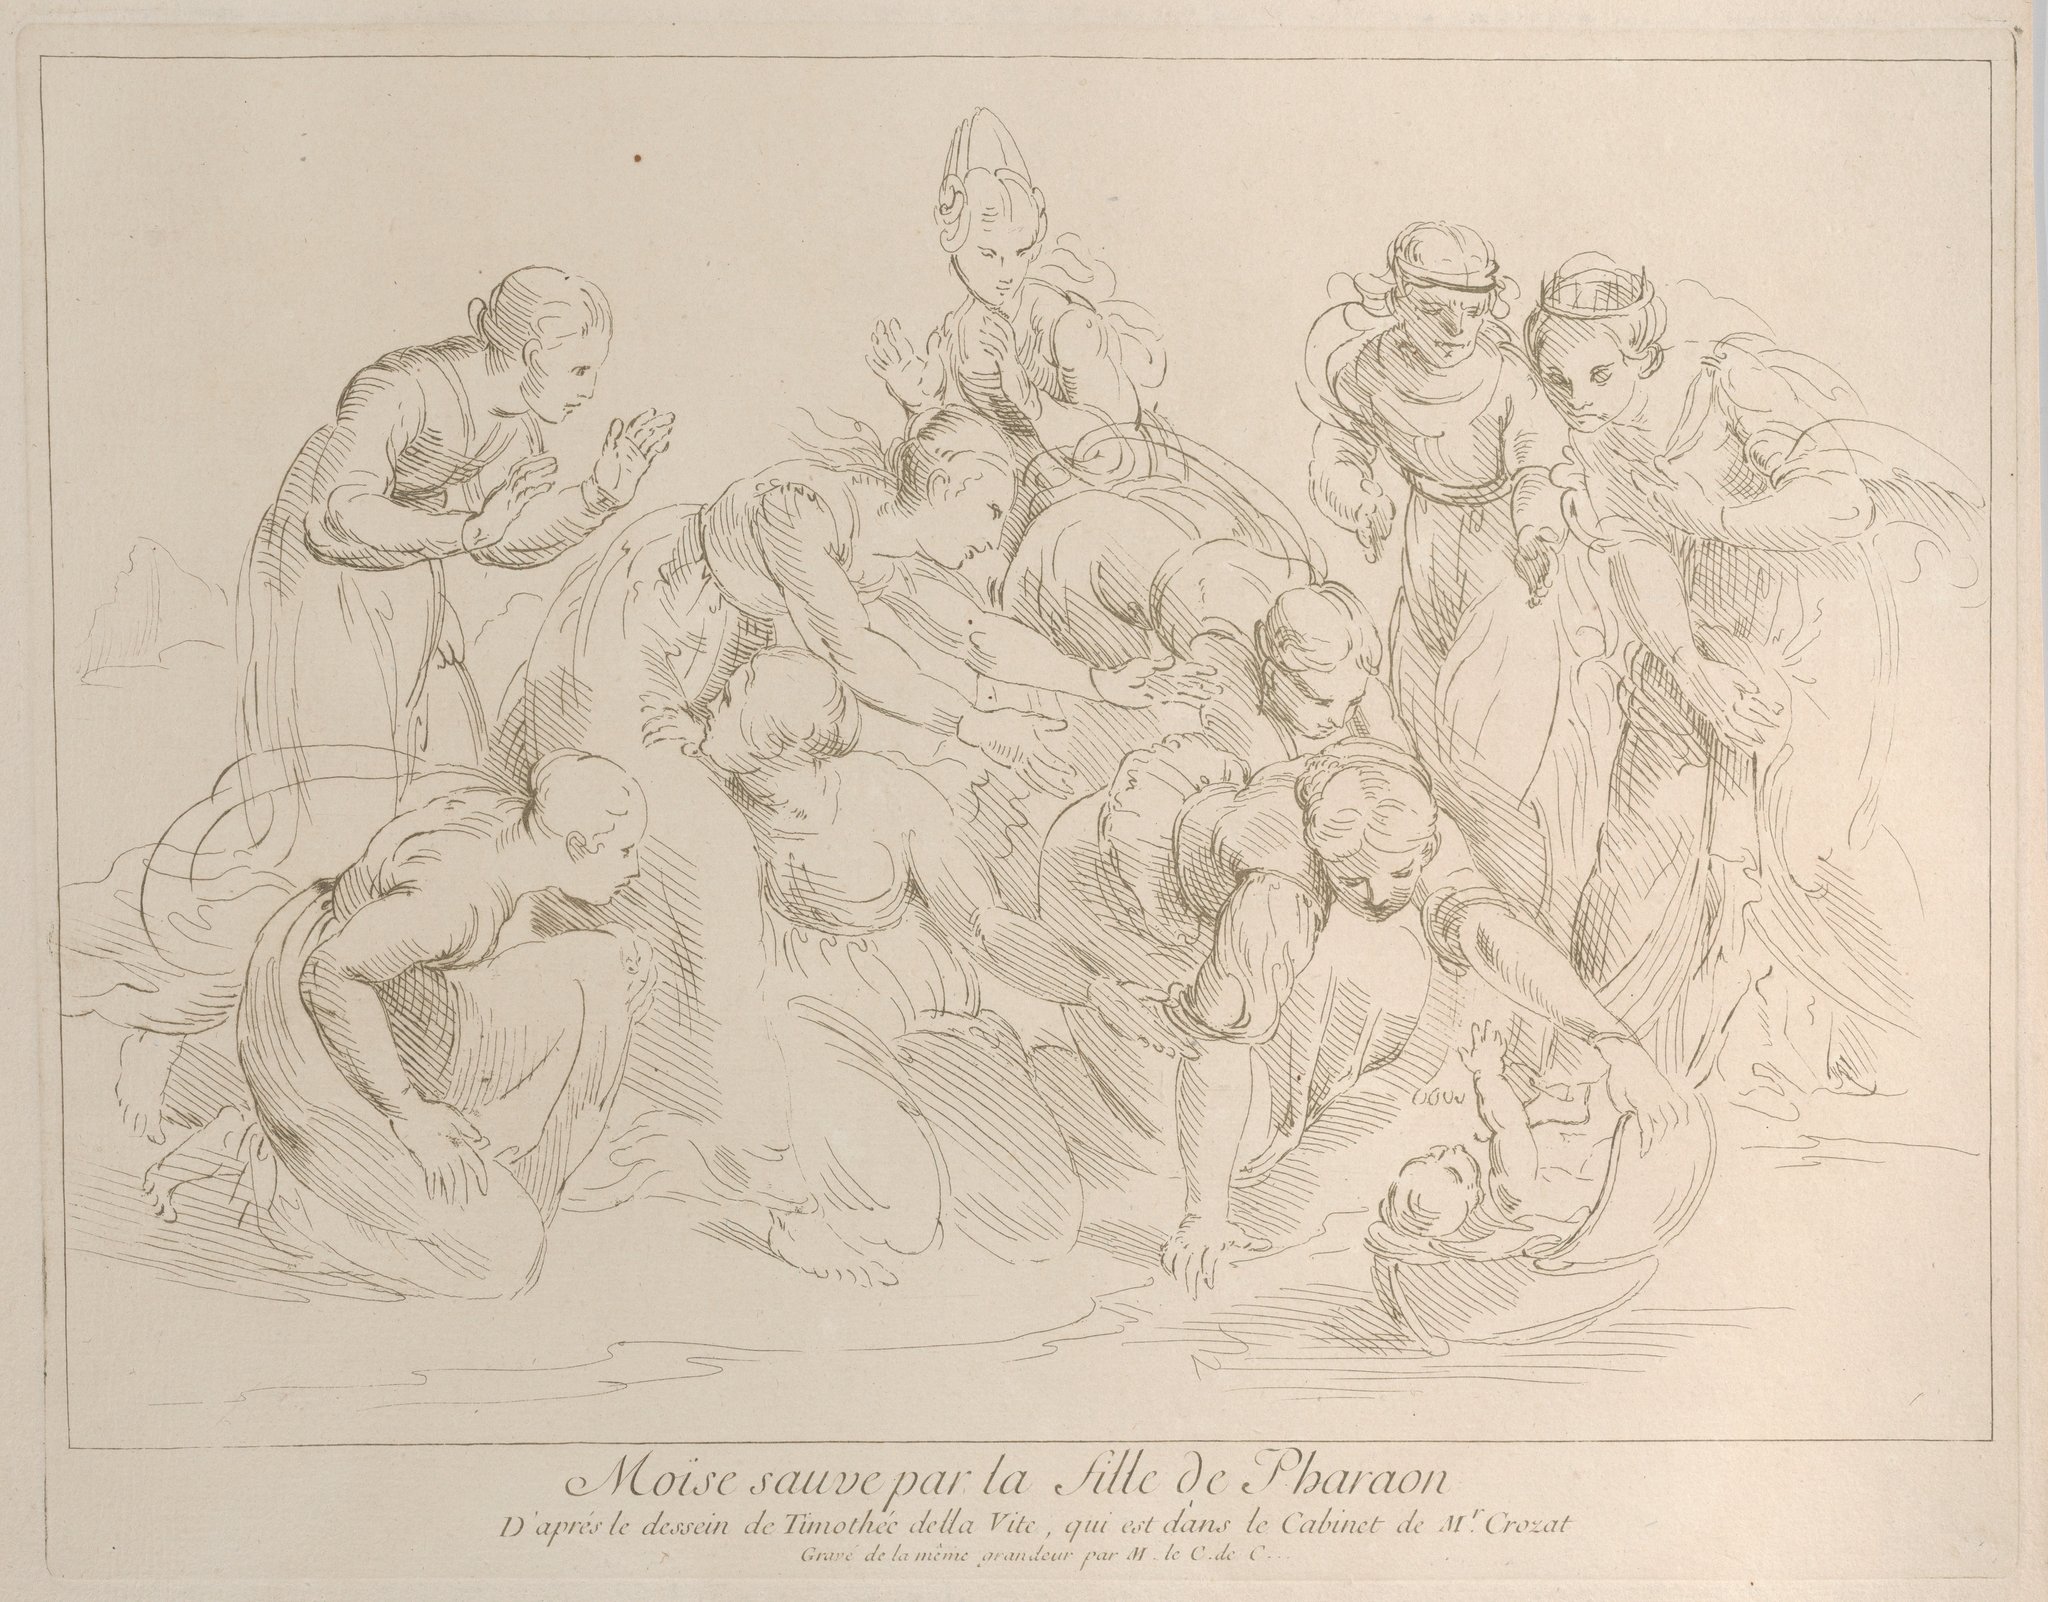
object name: print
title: Moses saved by the Pharaoh's daughter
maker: anne claude philippe de tubières, comte de caylus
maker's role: artist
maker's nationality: french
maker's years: 1692-1765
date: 1729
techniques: etching